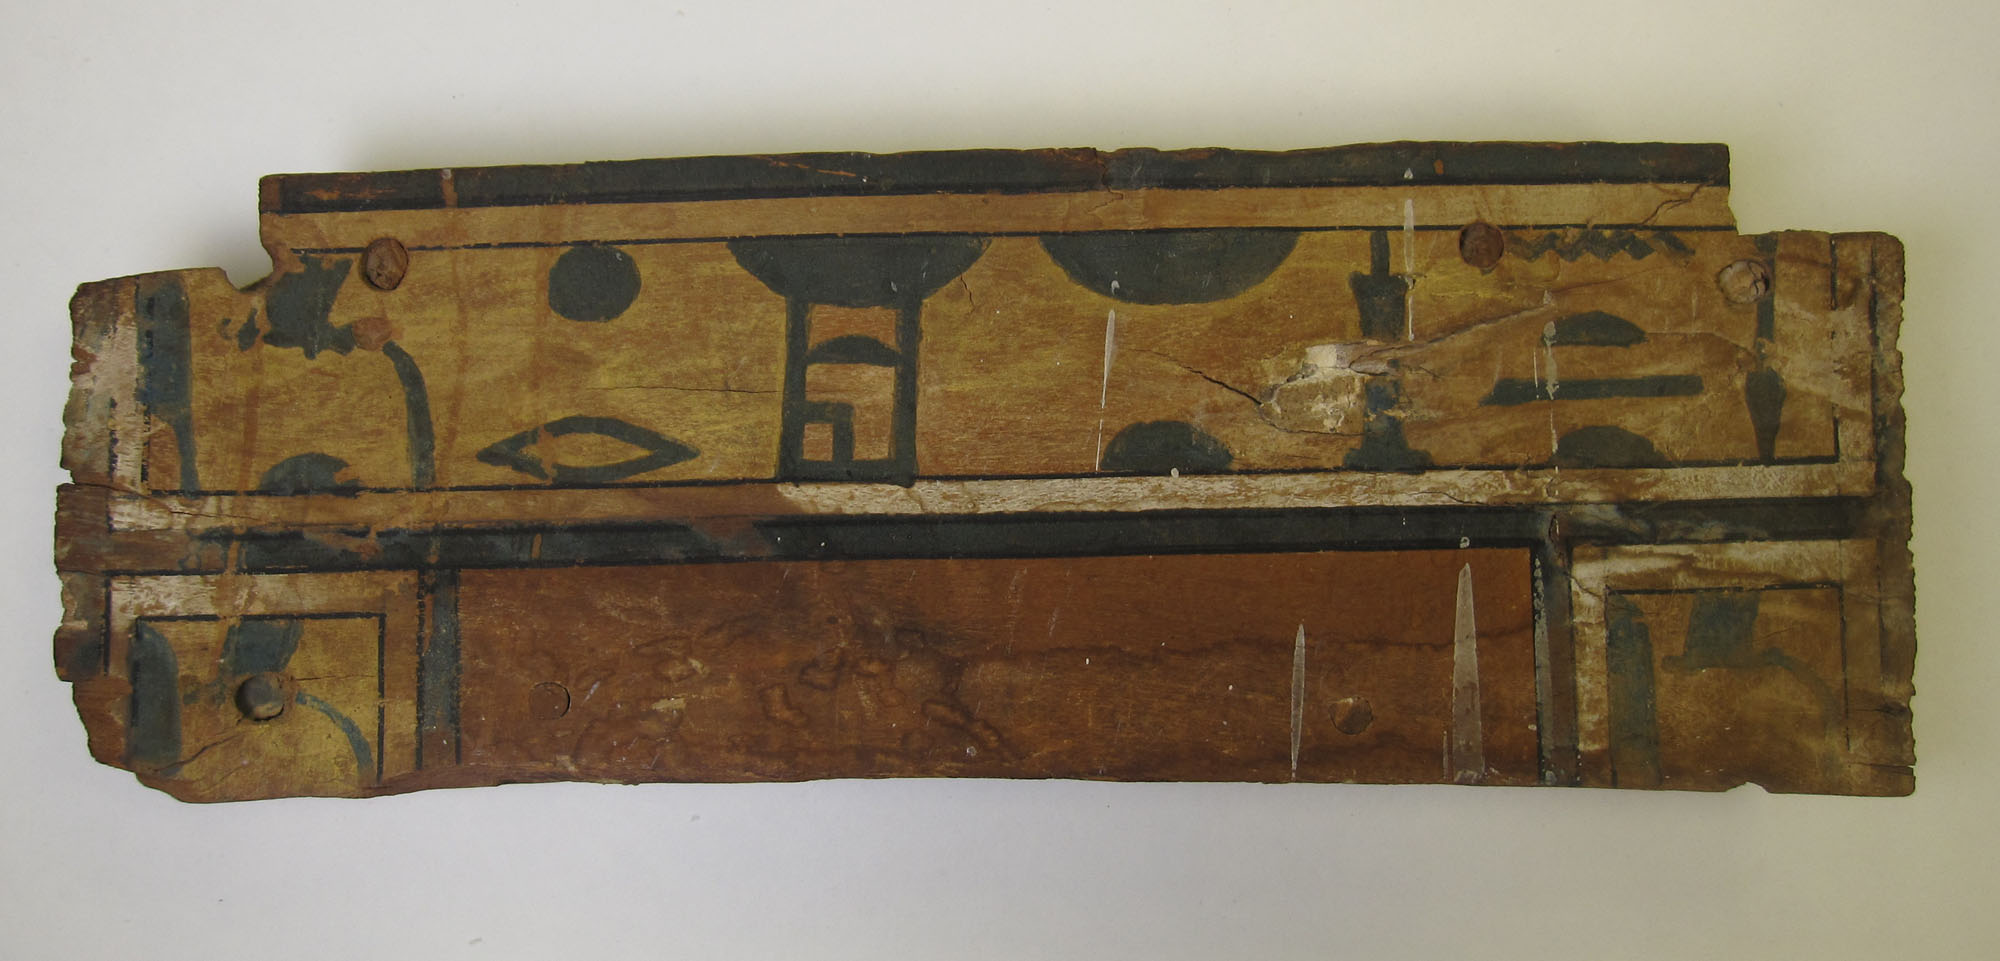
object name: coffin, fragment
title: Middle Kingdom Coffin Fragment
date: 2124-1981 BCE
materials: paint, wood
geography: egypt